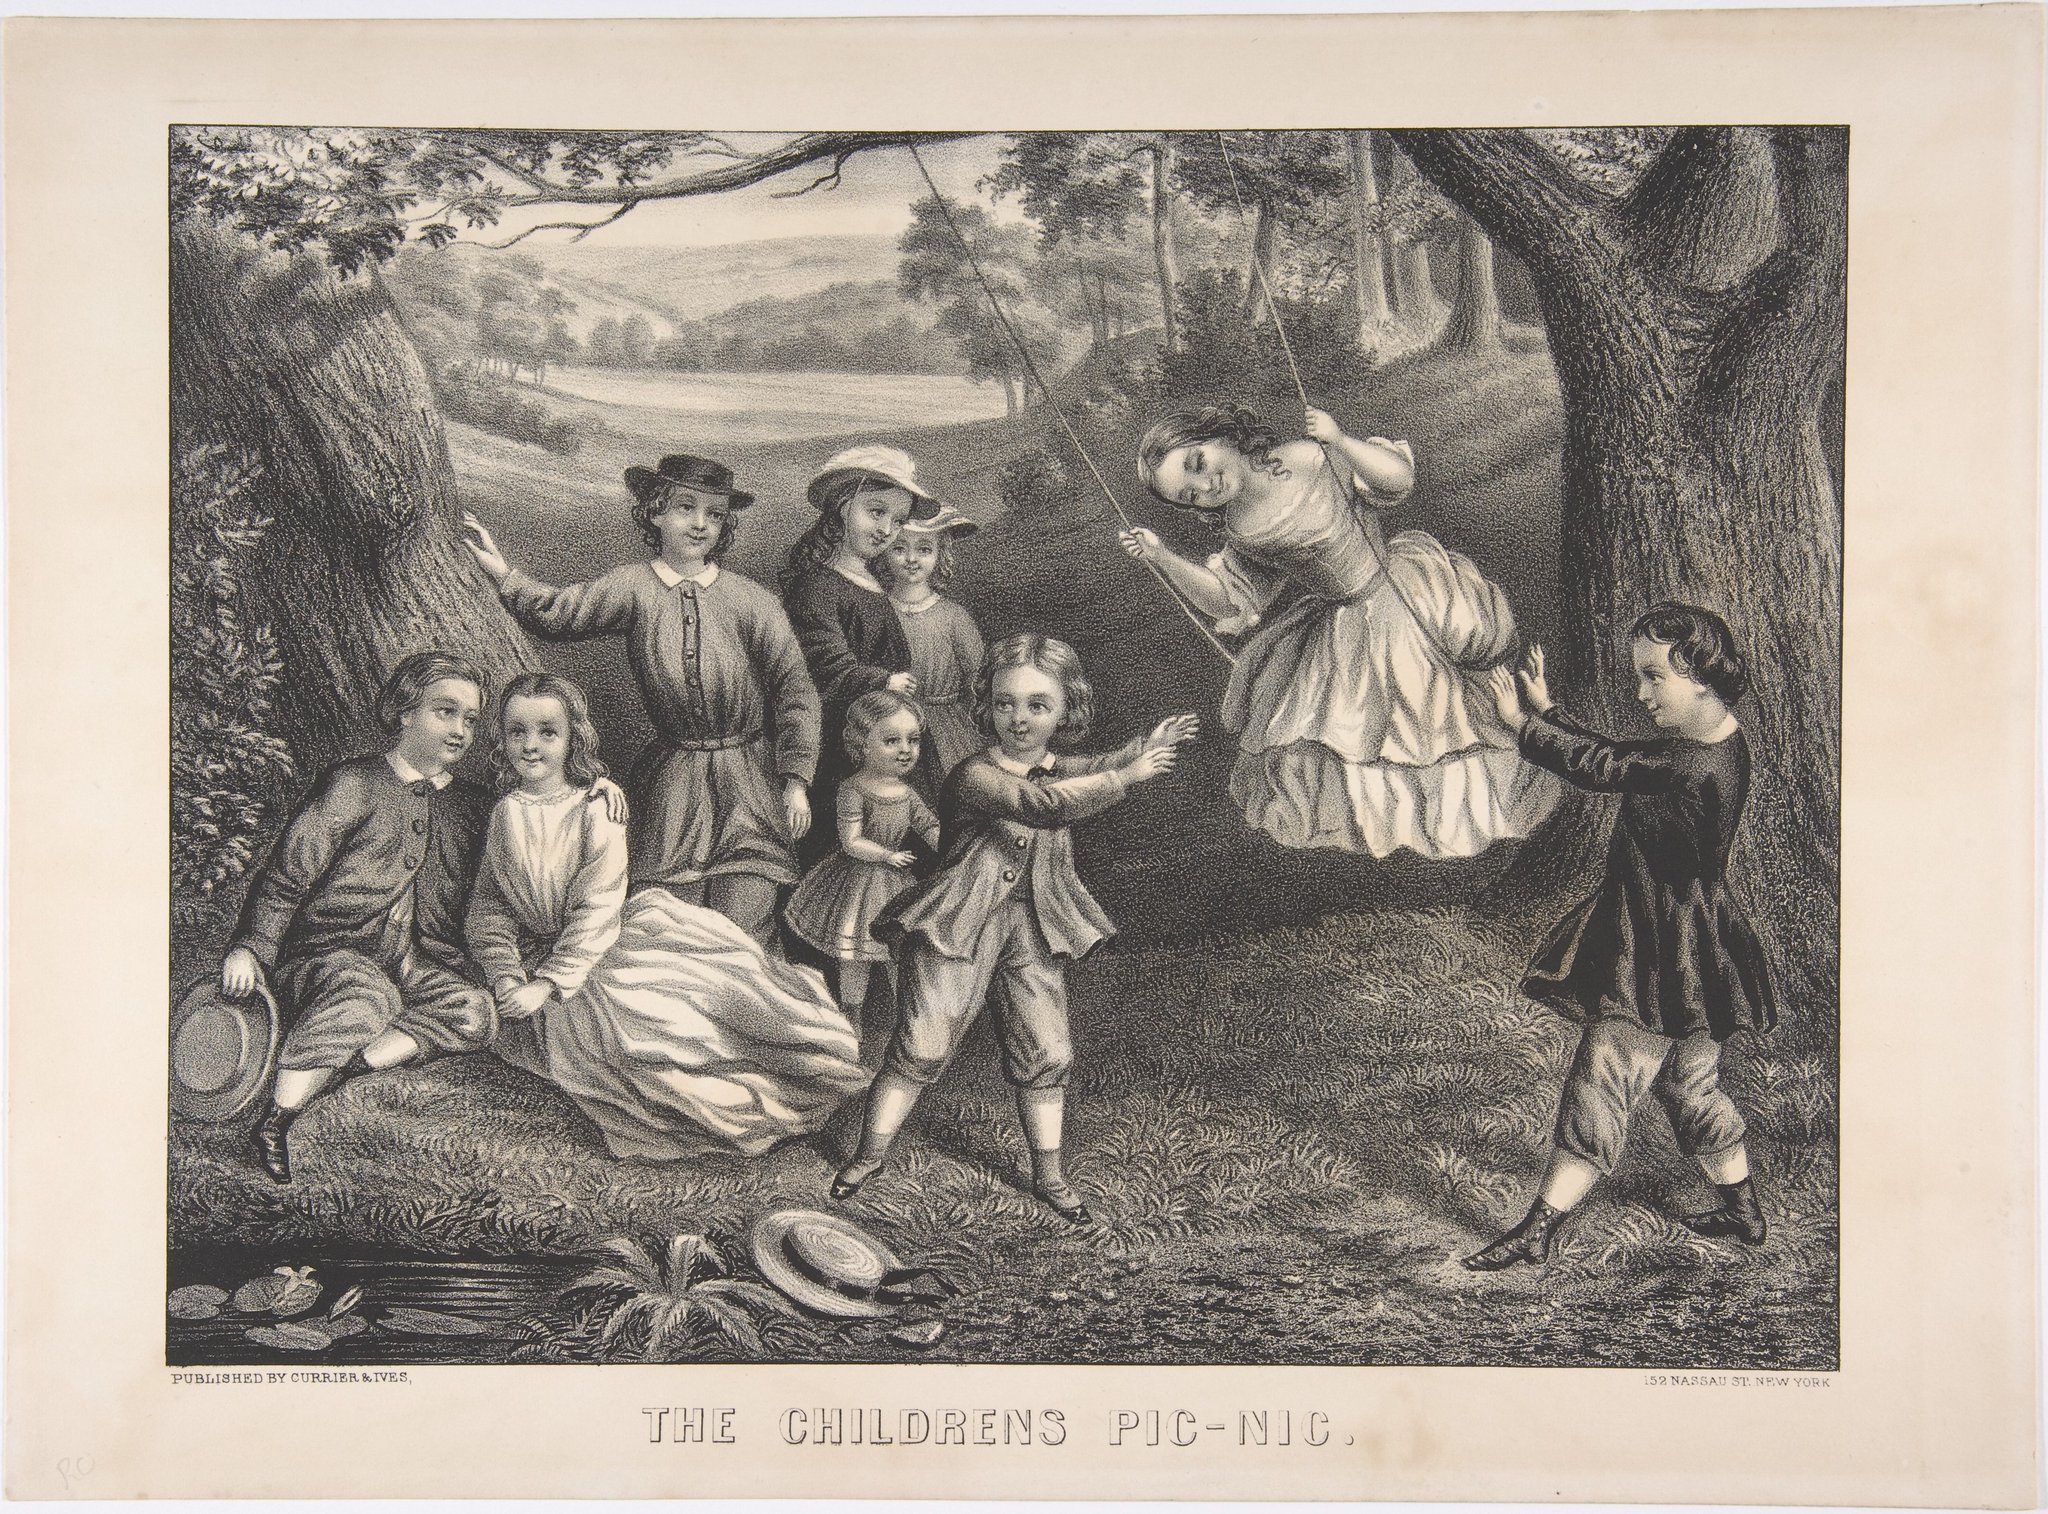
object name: print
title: The Children's Pic-Nic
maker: currier & ives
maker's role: publisher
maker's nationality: american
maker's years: 1857-1907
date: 1857-1871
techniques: lithograph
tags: boys,girls,playing